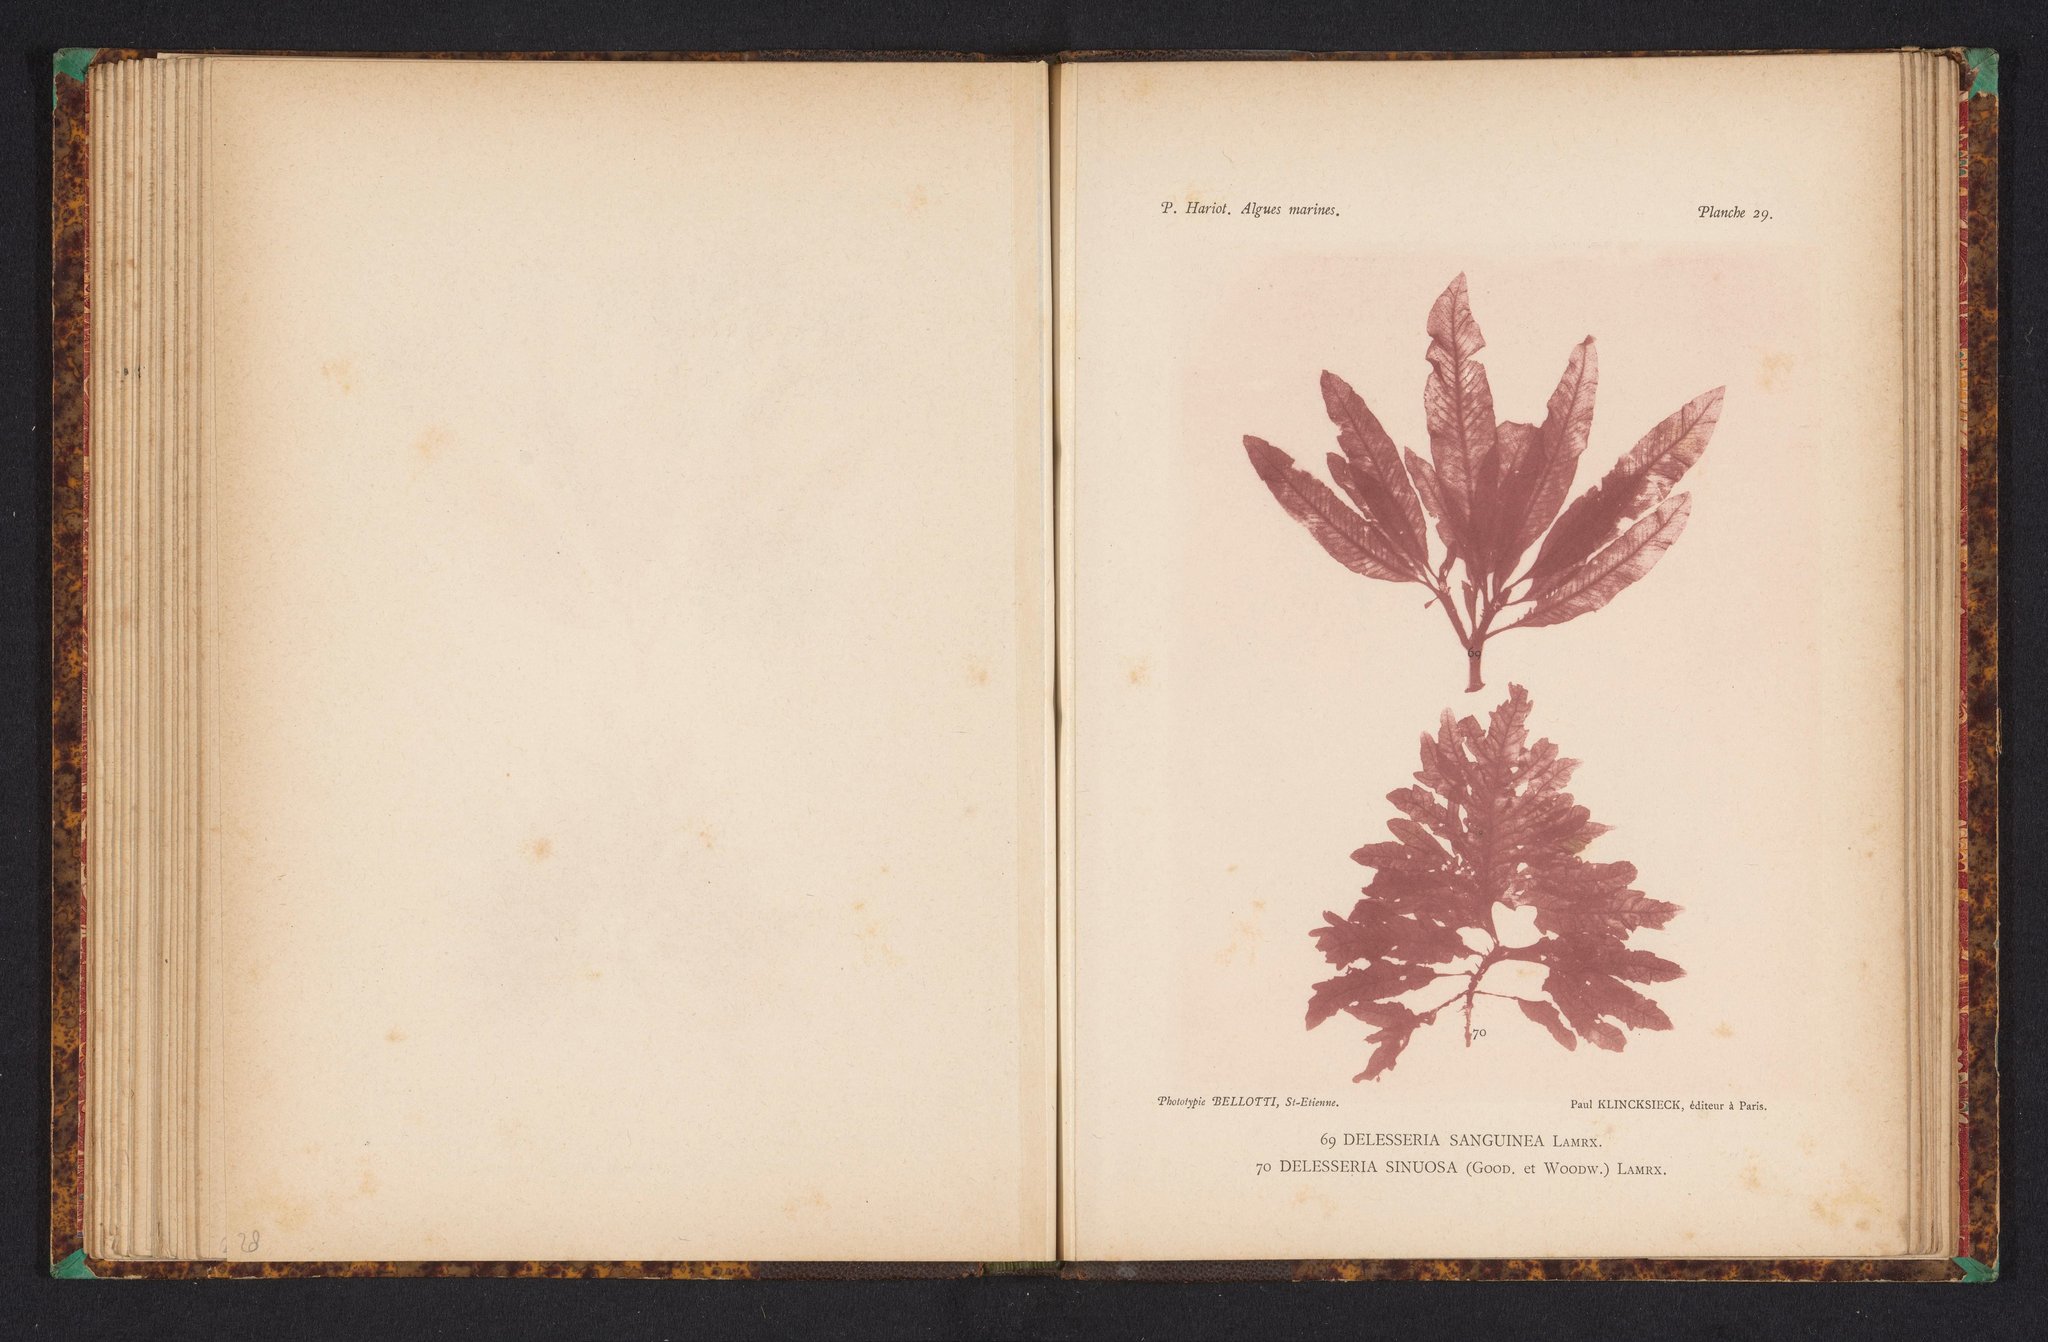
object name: photomechanical print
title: Twee soorten zeewier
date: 1882-1892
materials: paper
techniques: photograph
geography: france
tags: algae, seaweed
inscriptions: number: ‘69 (...) 70’, inscription: ‘Delesseria (...) sinuosa (Good. et Woodw.) Lamrx.’, number: ‘Planche 29.’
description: (69) is Delesseria sanguinea, (70) is Delesseria sinuosa.